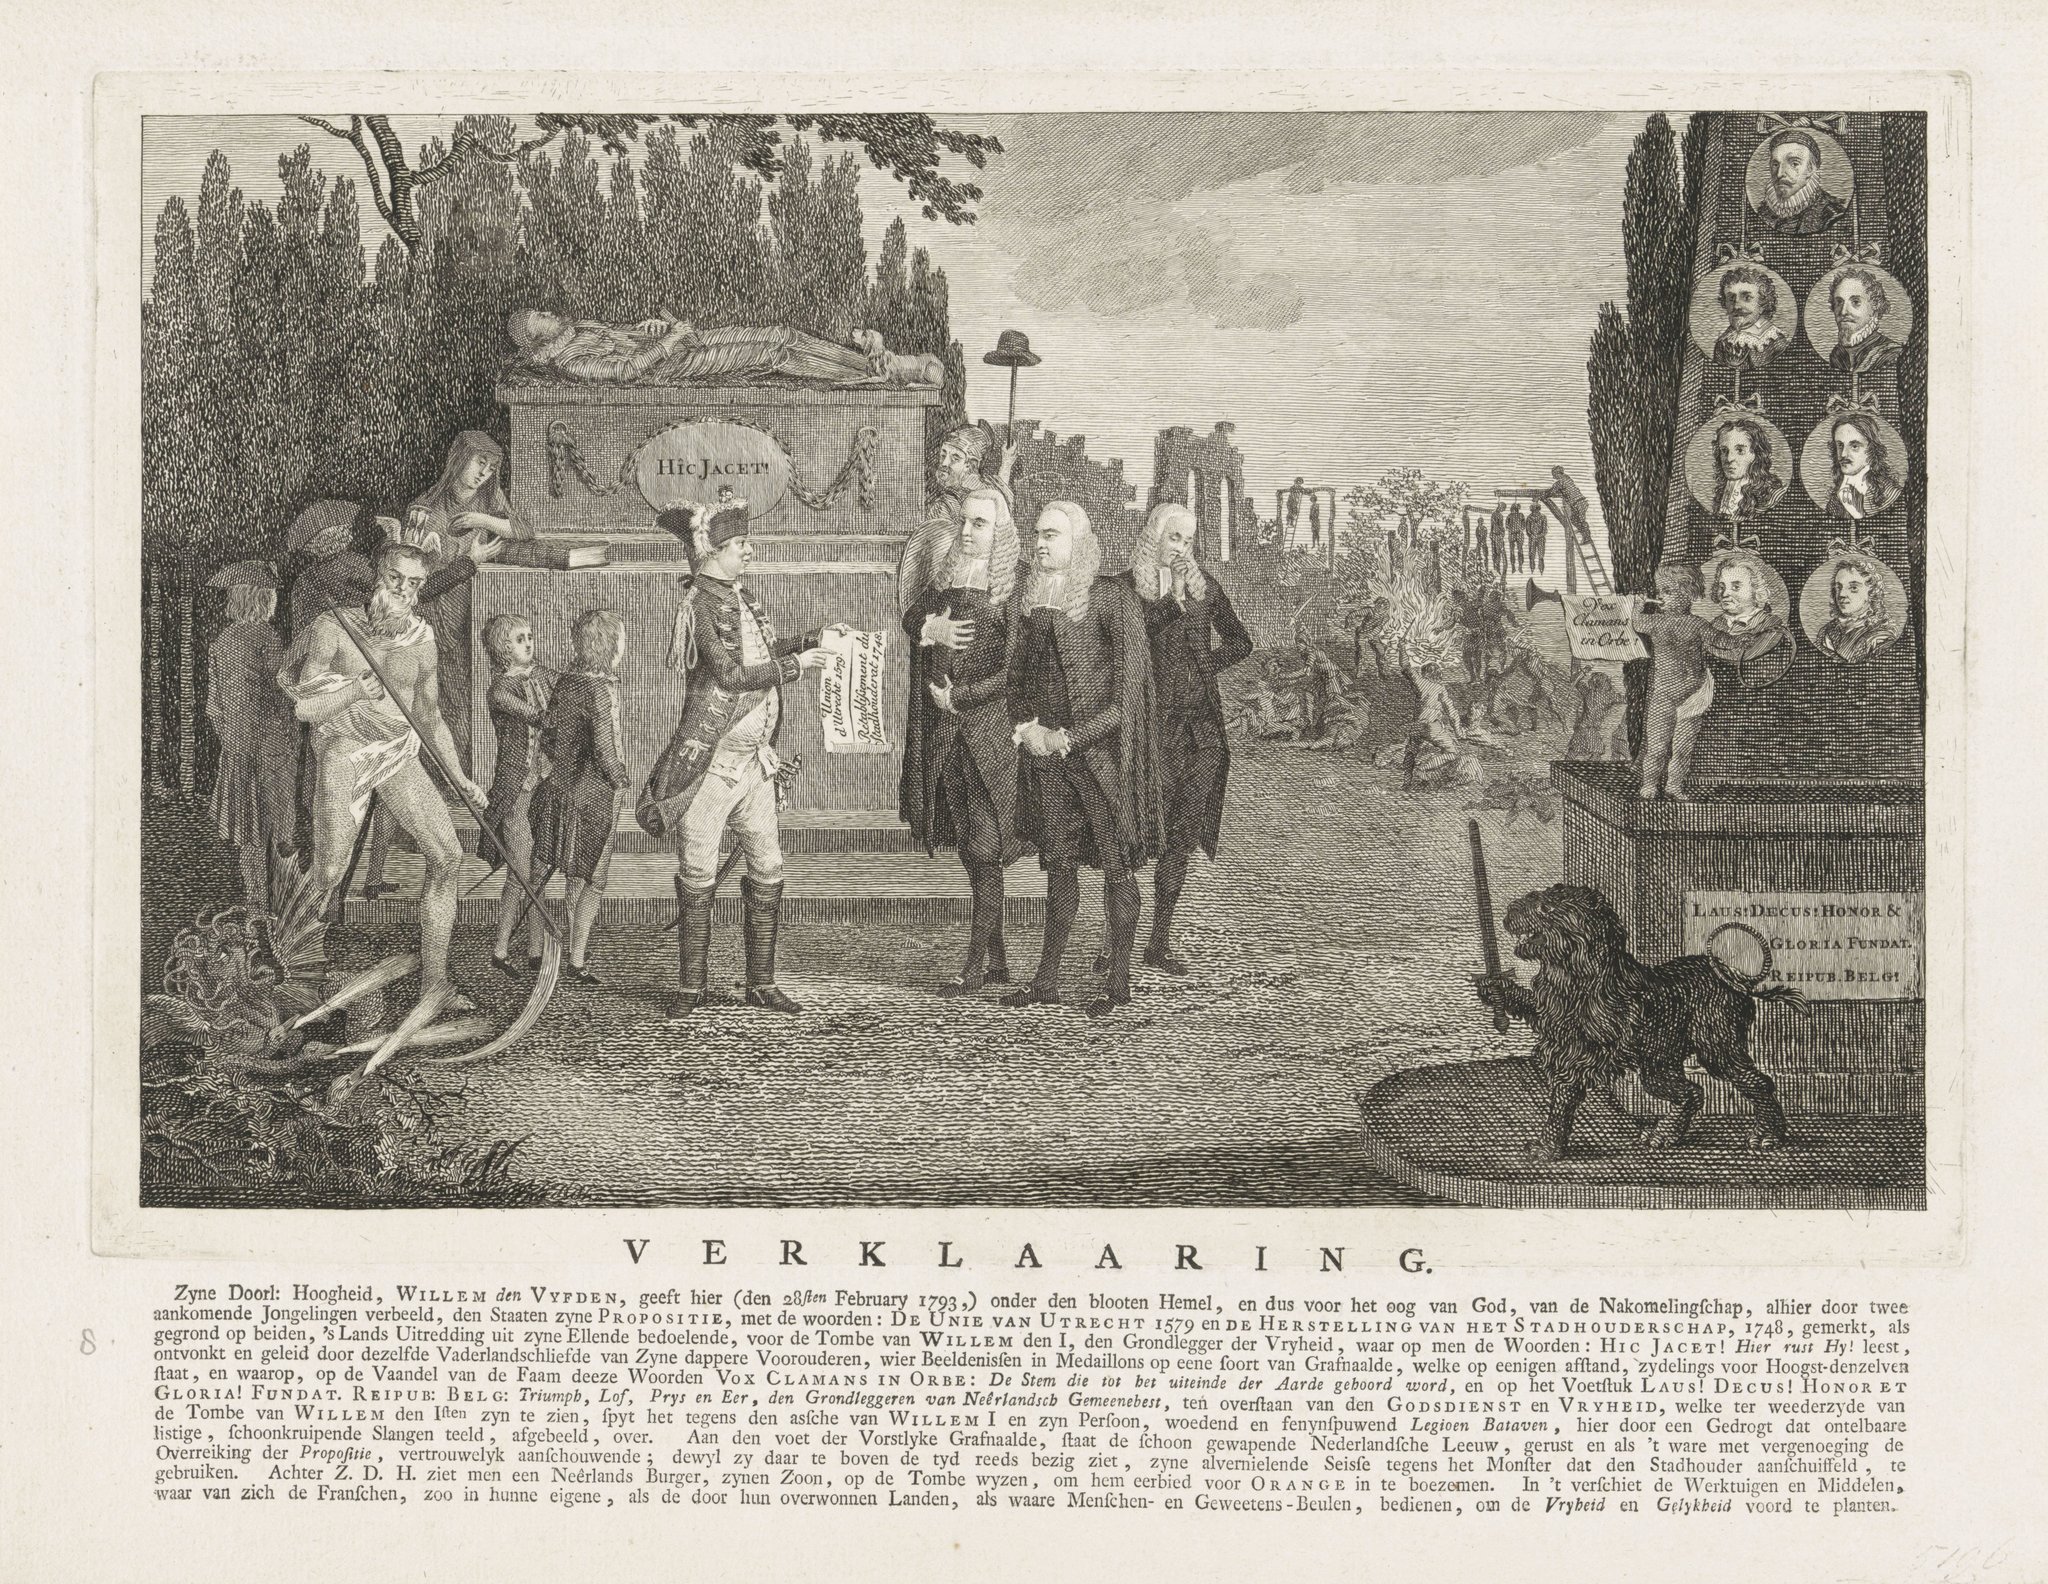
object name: print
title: Allegorie waarin Willem V zijn propositie aan de Staten geeft, 1793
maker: Anonymous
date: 1793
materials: paper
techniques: engraving, etching, letterpress printing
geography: northern netherlands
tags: the hague, william v (prince of orange), violent death ~ maltreatment, torture, grave-building, monumental tomb, father time, man with wings and scythe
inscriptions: collector's mark: Lugt 2228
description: Allegorie waarin stadhouder Willem V zijn propositie aan de drie vertegenwoordigers van de Staten-Generaal geeft, 28 februari 1793. Stadhouder Willem V staat, vergezeld door twee jongens (zijn zoons), bij de graftombe van Willem van Oranje. Links bestrijdt Vader Tijd het monster van de Laster, rechts een monument met portretten van de voorgangers van Willem V. Op de achtergrond moordpartijen aangericht onder de Nederlanders door de Fransen onder het mom van Vrijheid en Gelijkheid. Op het blad onder de plaat een verklaring van de voorstelling.